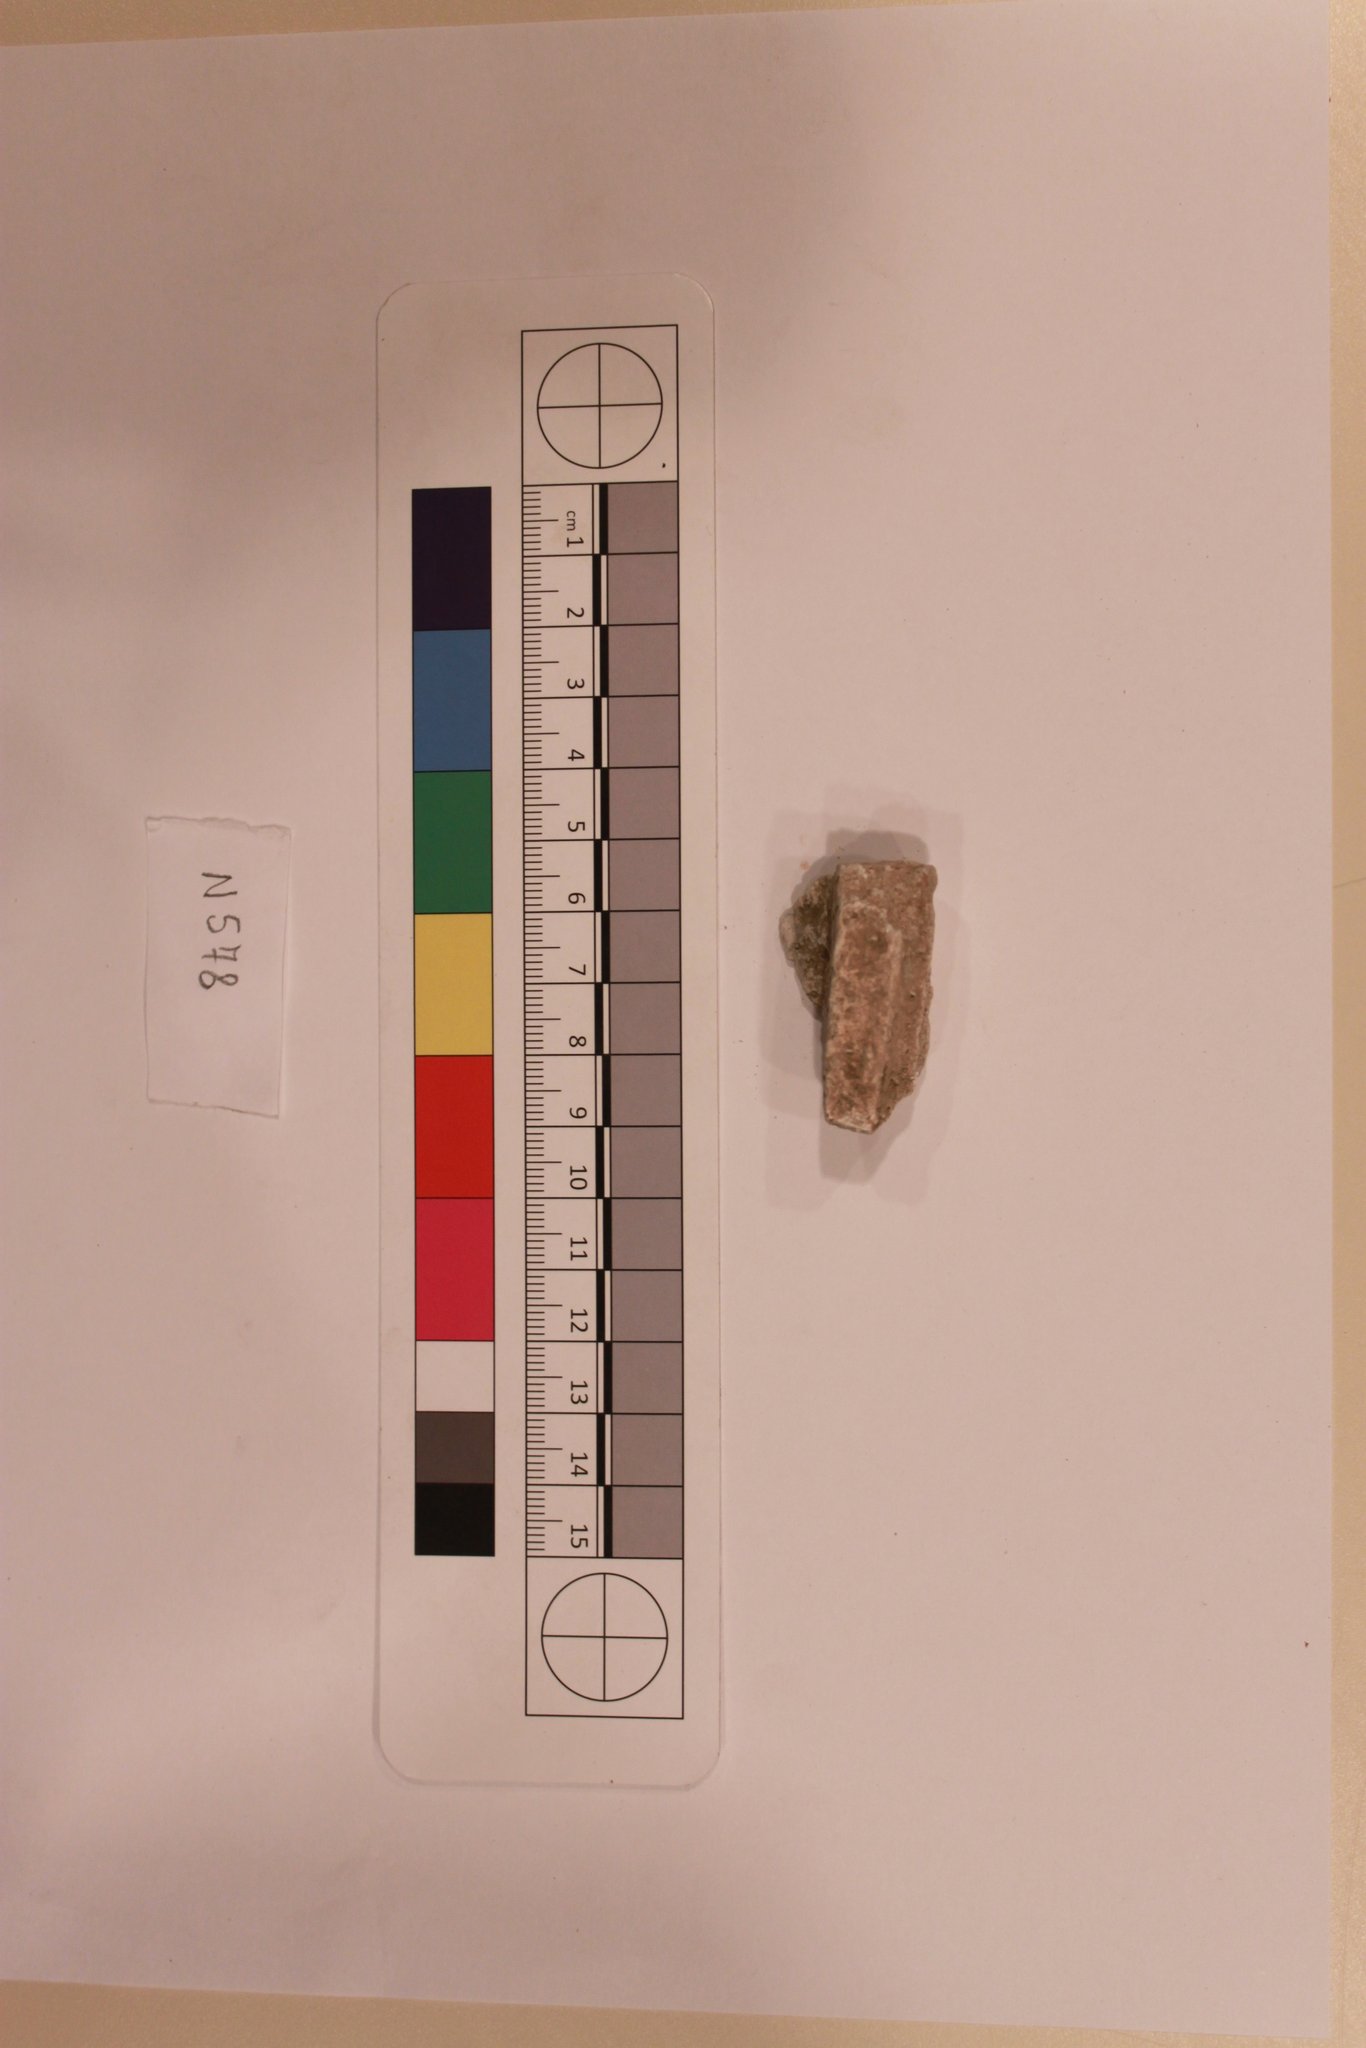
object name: fragment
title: Stucco Fragment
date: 701-1200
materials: plaster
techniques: carving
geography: iran